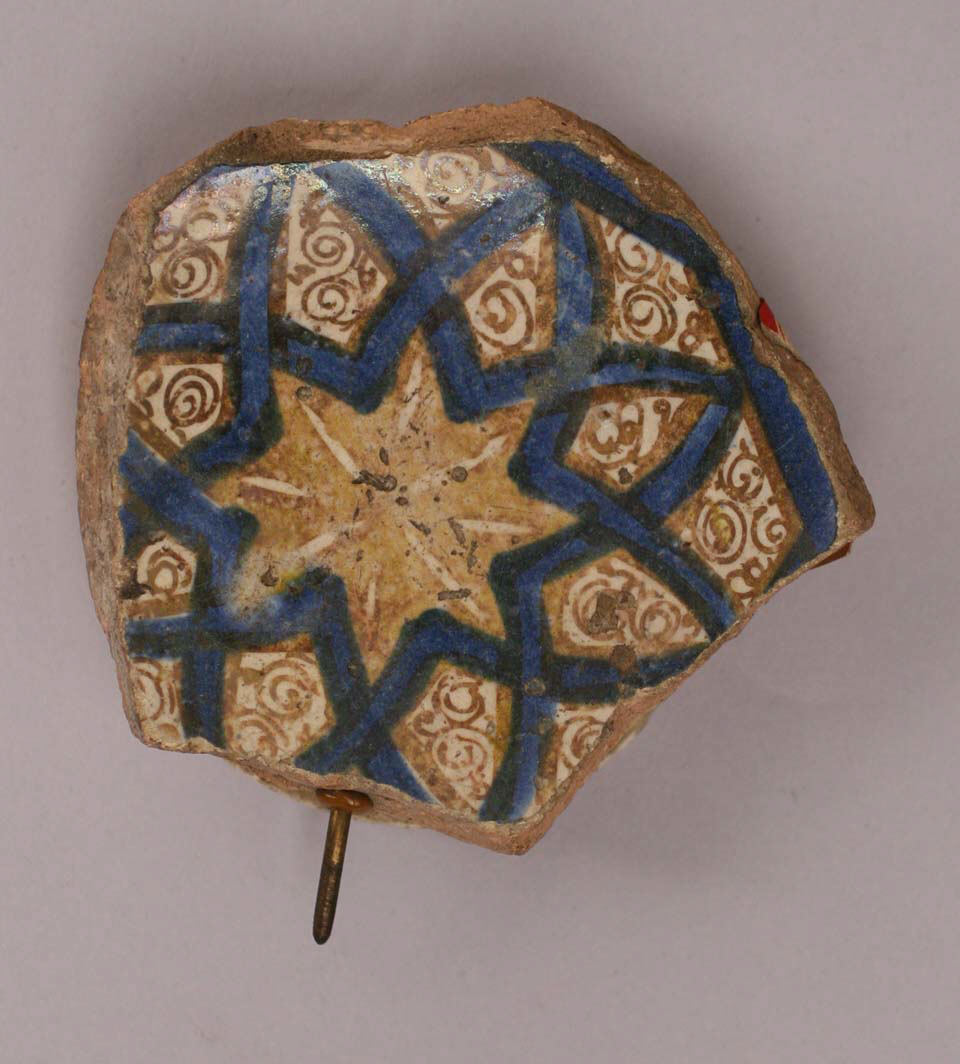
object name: fragment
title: Ceramic Fragment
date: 1416-1458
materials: earthenware, glaze, paint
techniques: underglaze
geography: egypt